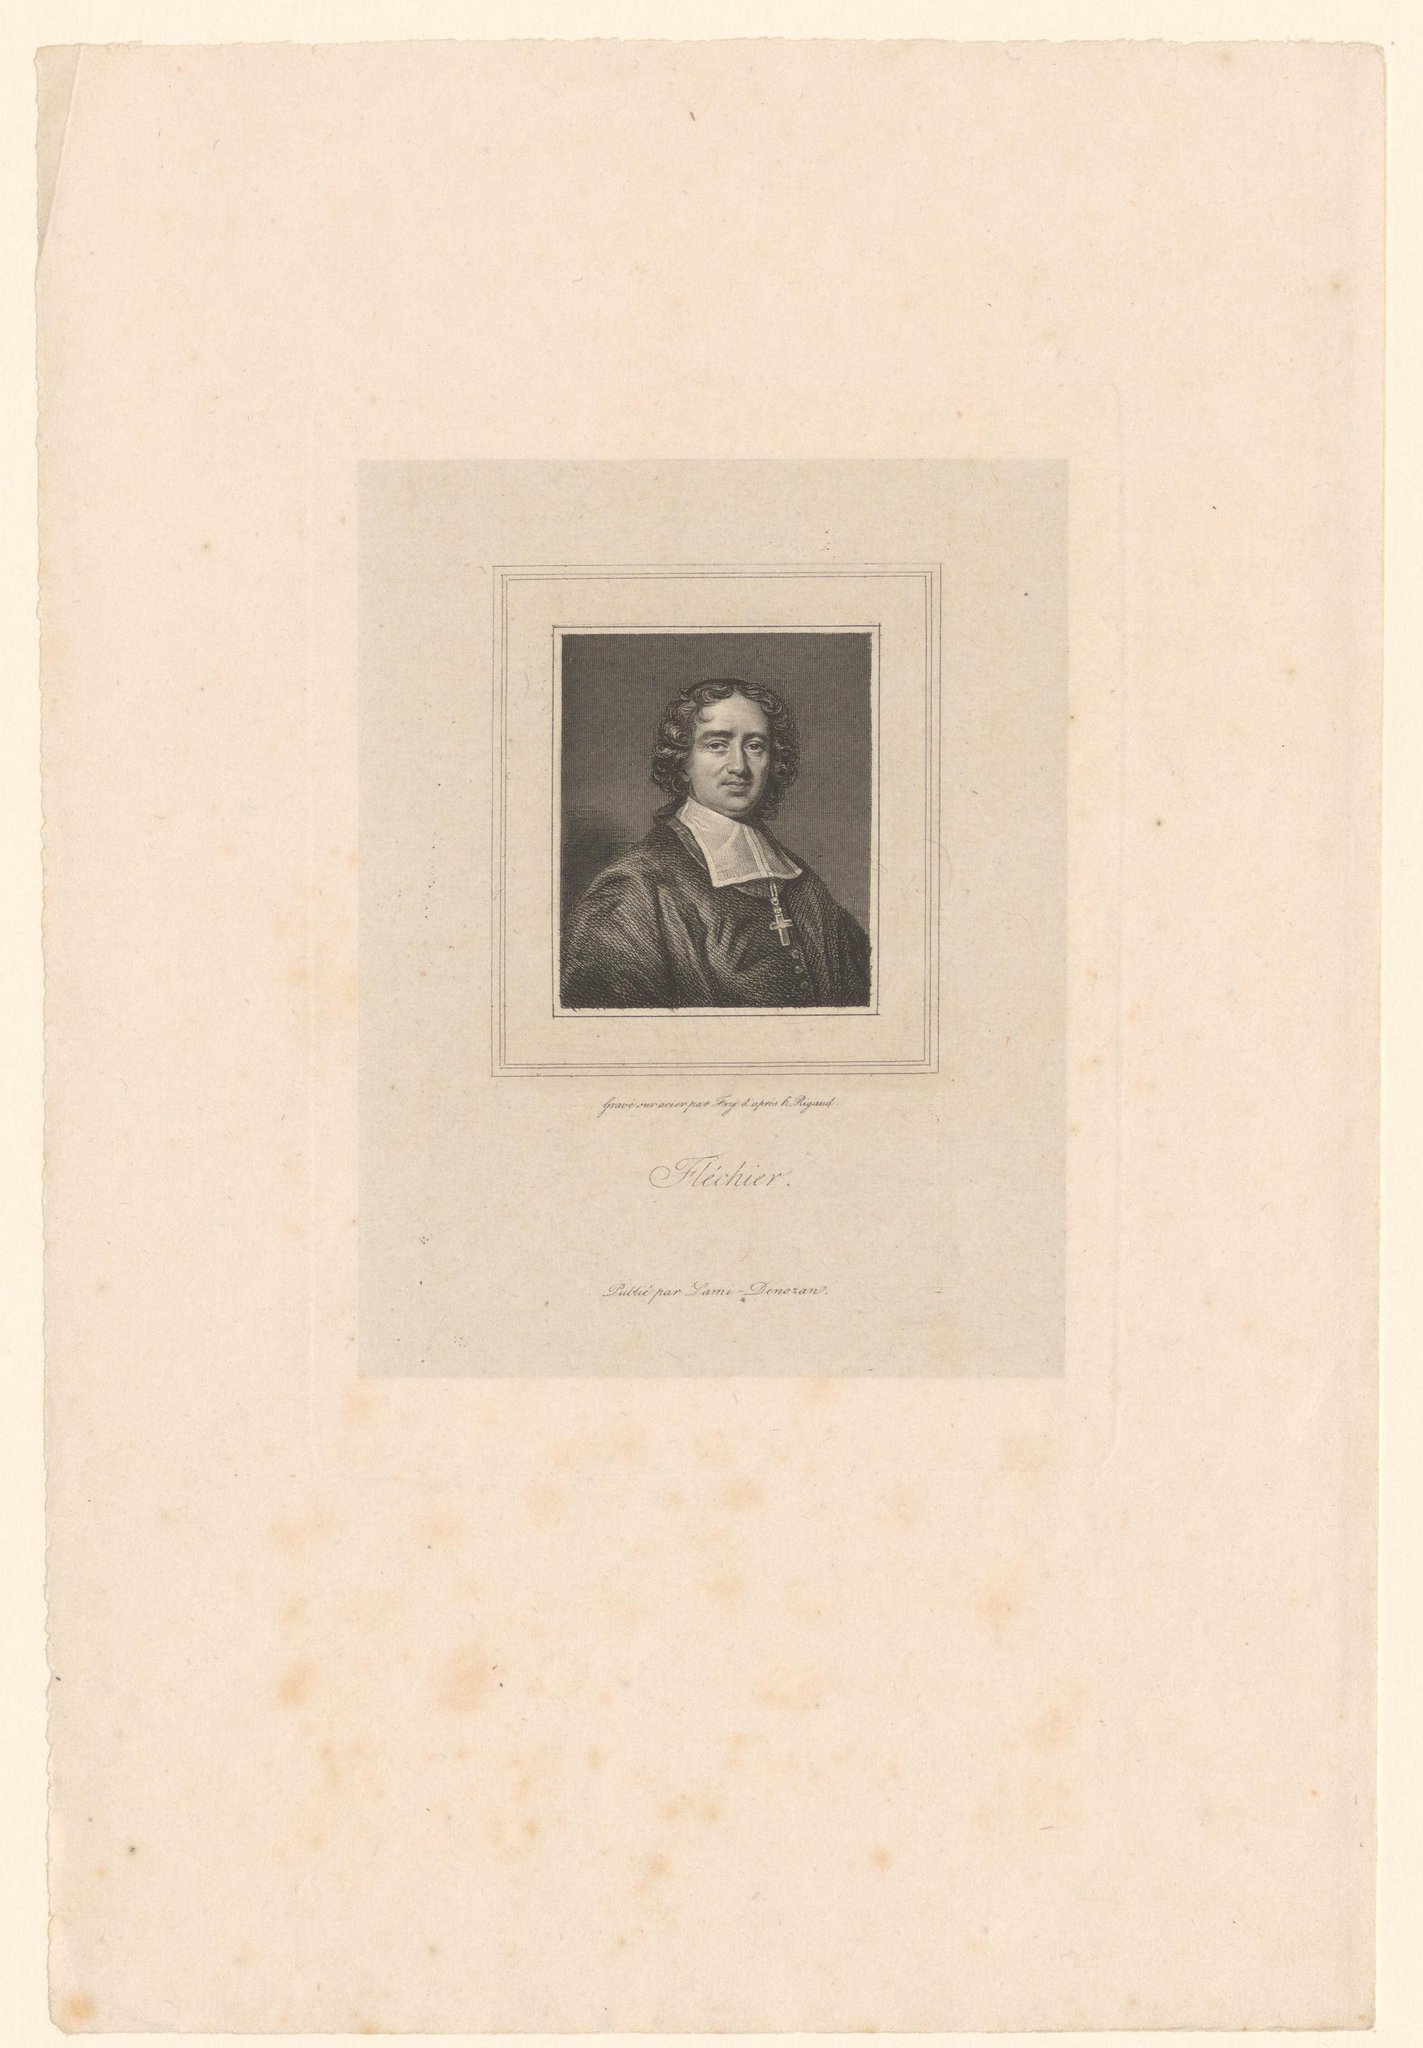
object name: print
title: Fléchier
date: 1799-1843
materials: paper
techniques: etching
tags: priest, theologian, historical persons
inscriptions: collector's mark: Lugt 2228